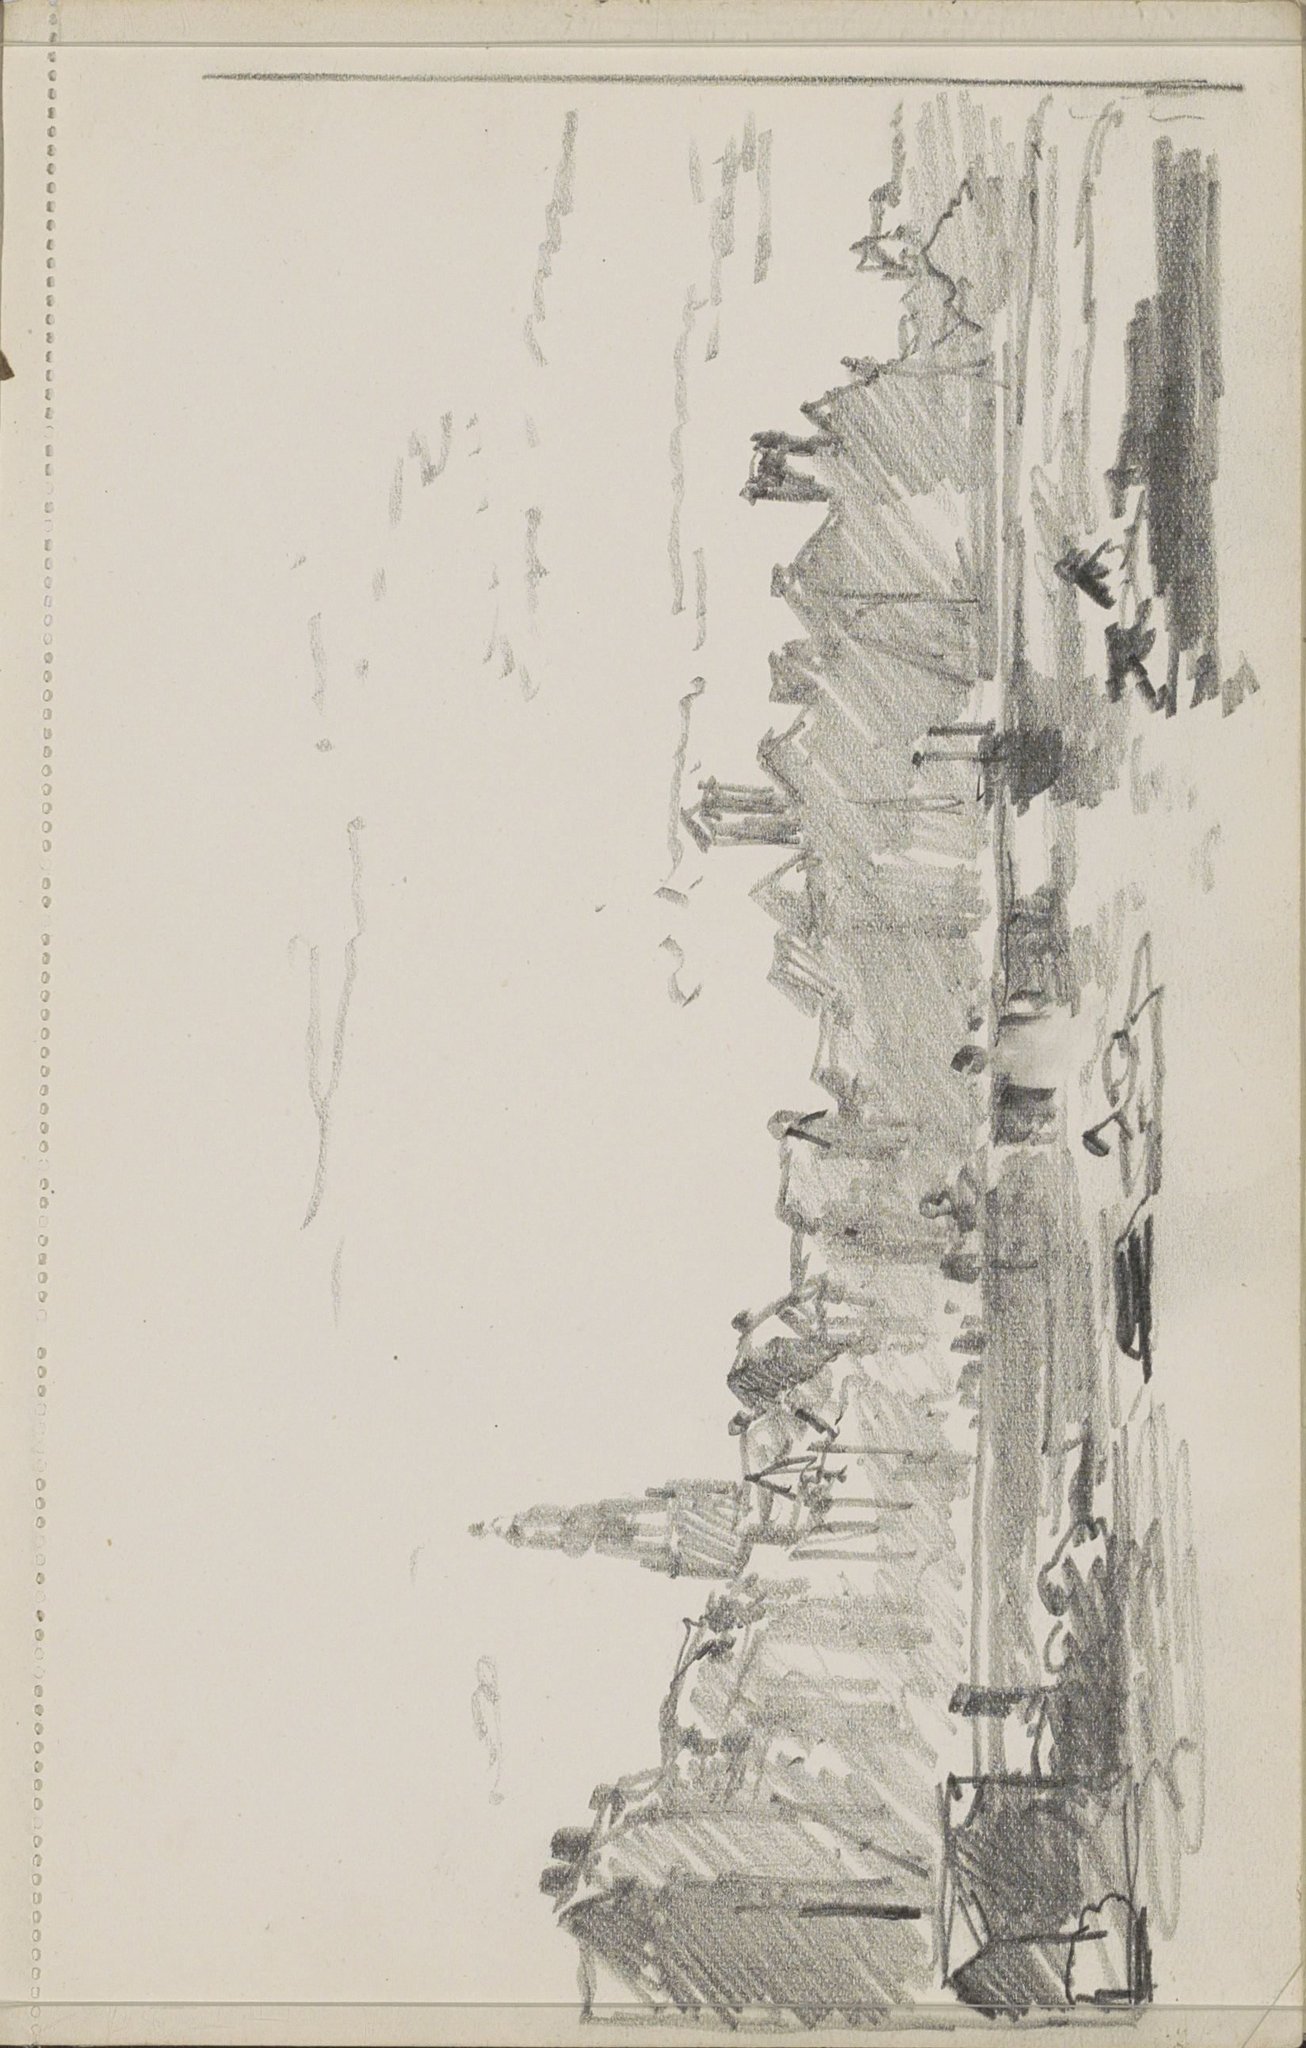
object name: sketchbook leaf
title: Damrak met de toren van de Oude Kerk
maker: cornelis vreedenburgh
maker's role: draughtsman, print maker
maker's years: 1880-1946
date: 1890-1946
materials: paper, pencil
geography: amsterdam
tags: city-view, and landscape with man-made constructions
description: Blad 9 recto uit een schetsboek met 61 bladen.